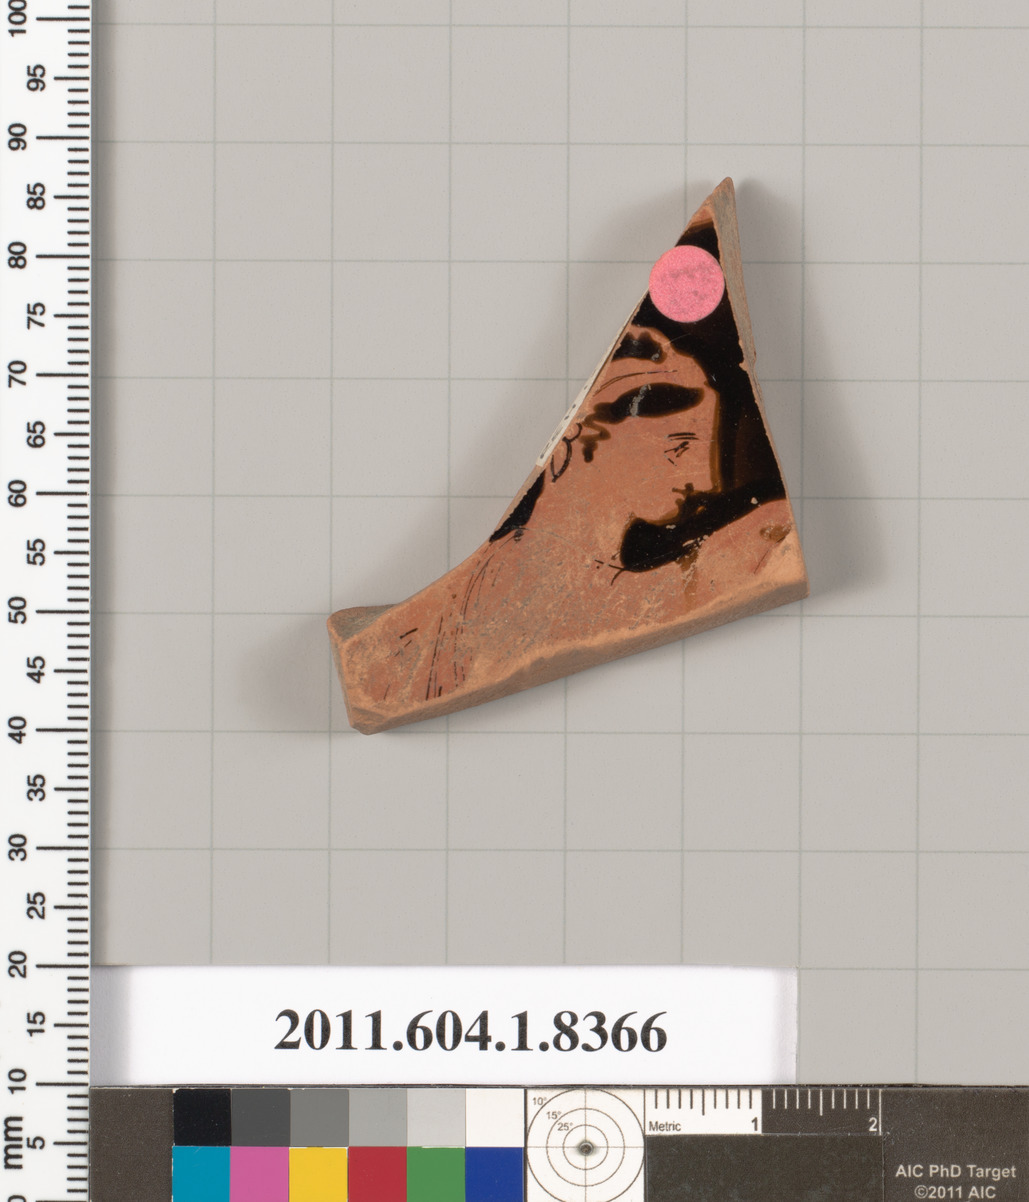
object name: kylix fragment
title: Terracotta fragment of a kylix (drinking cup)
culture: greek, attic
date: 400-351 BCE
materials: terracotta